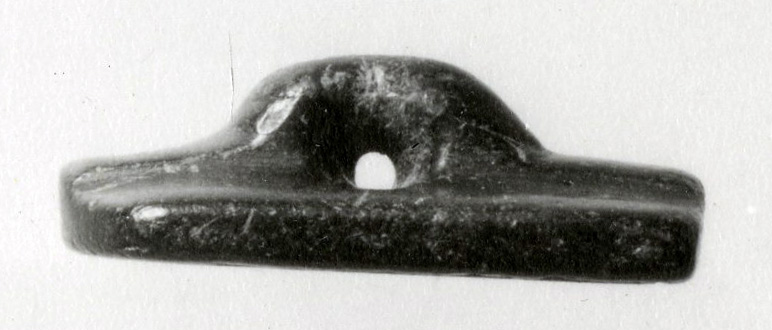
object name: seal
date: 1950 BCE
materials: stone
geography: egypt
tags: hieroglyphs